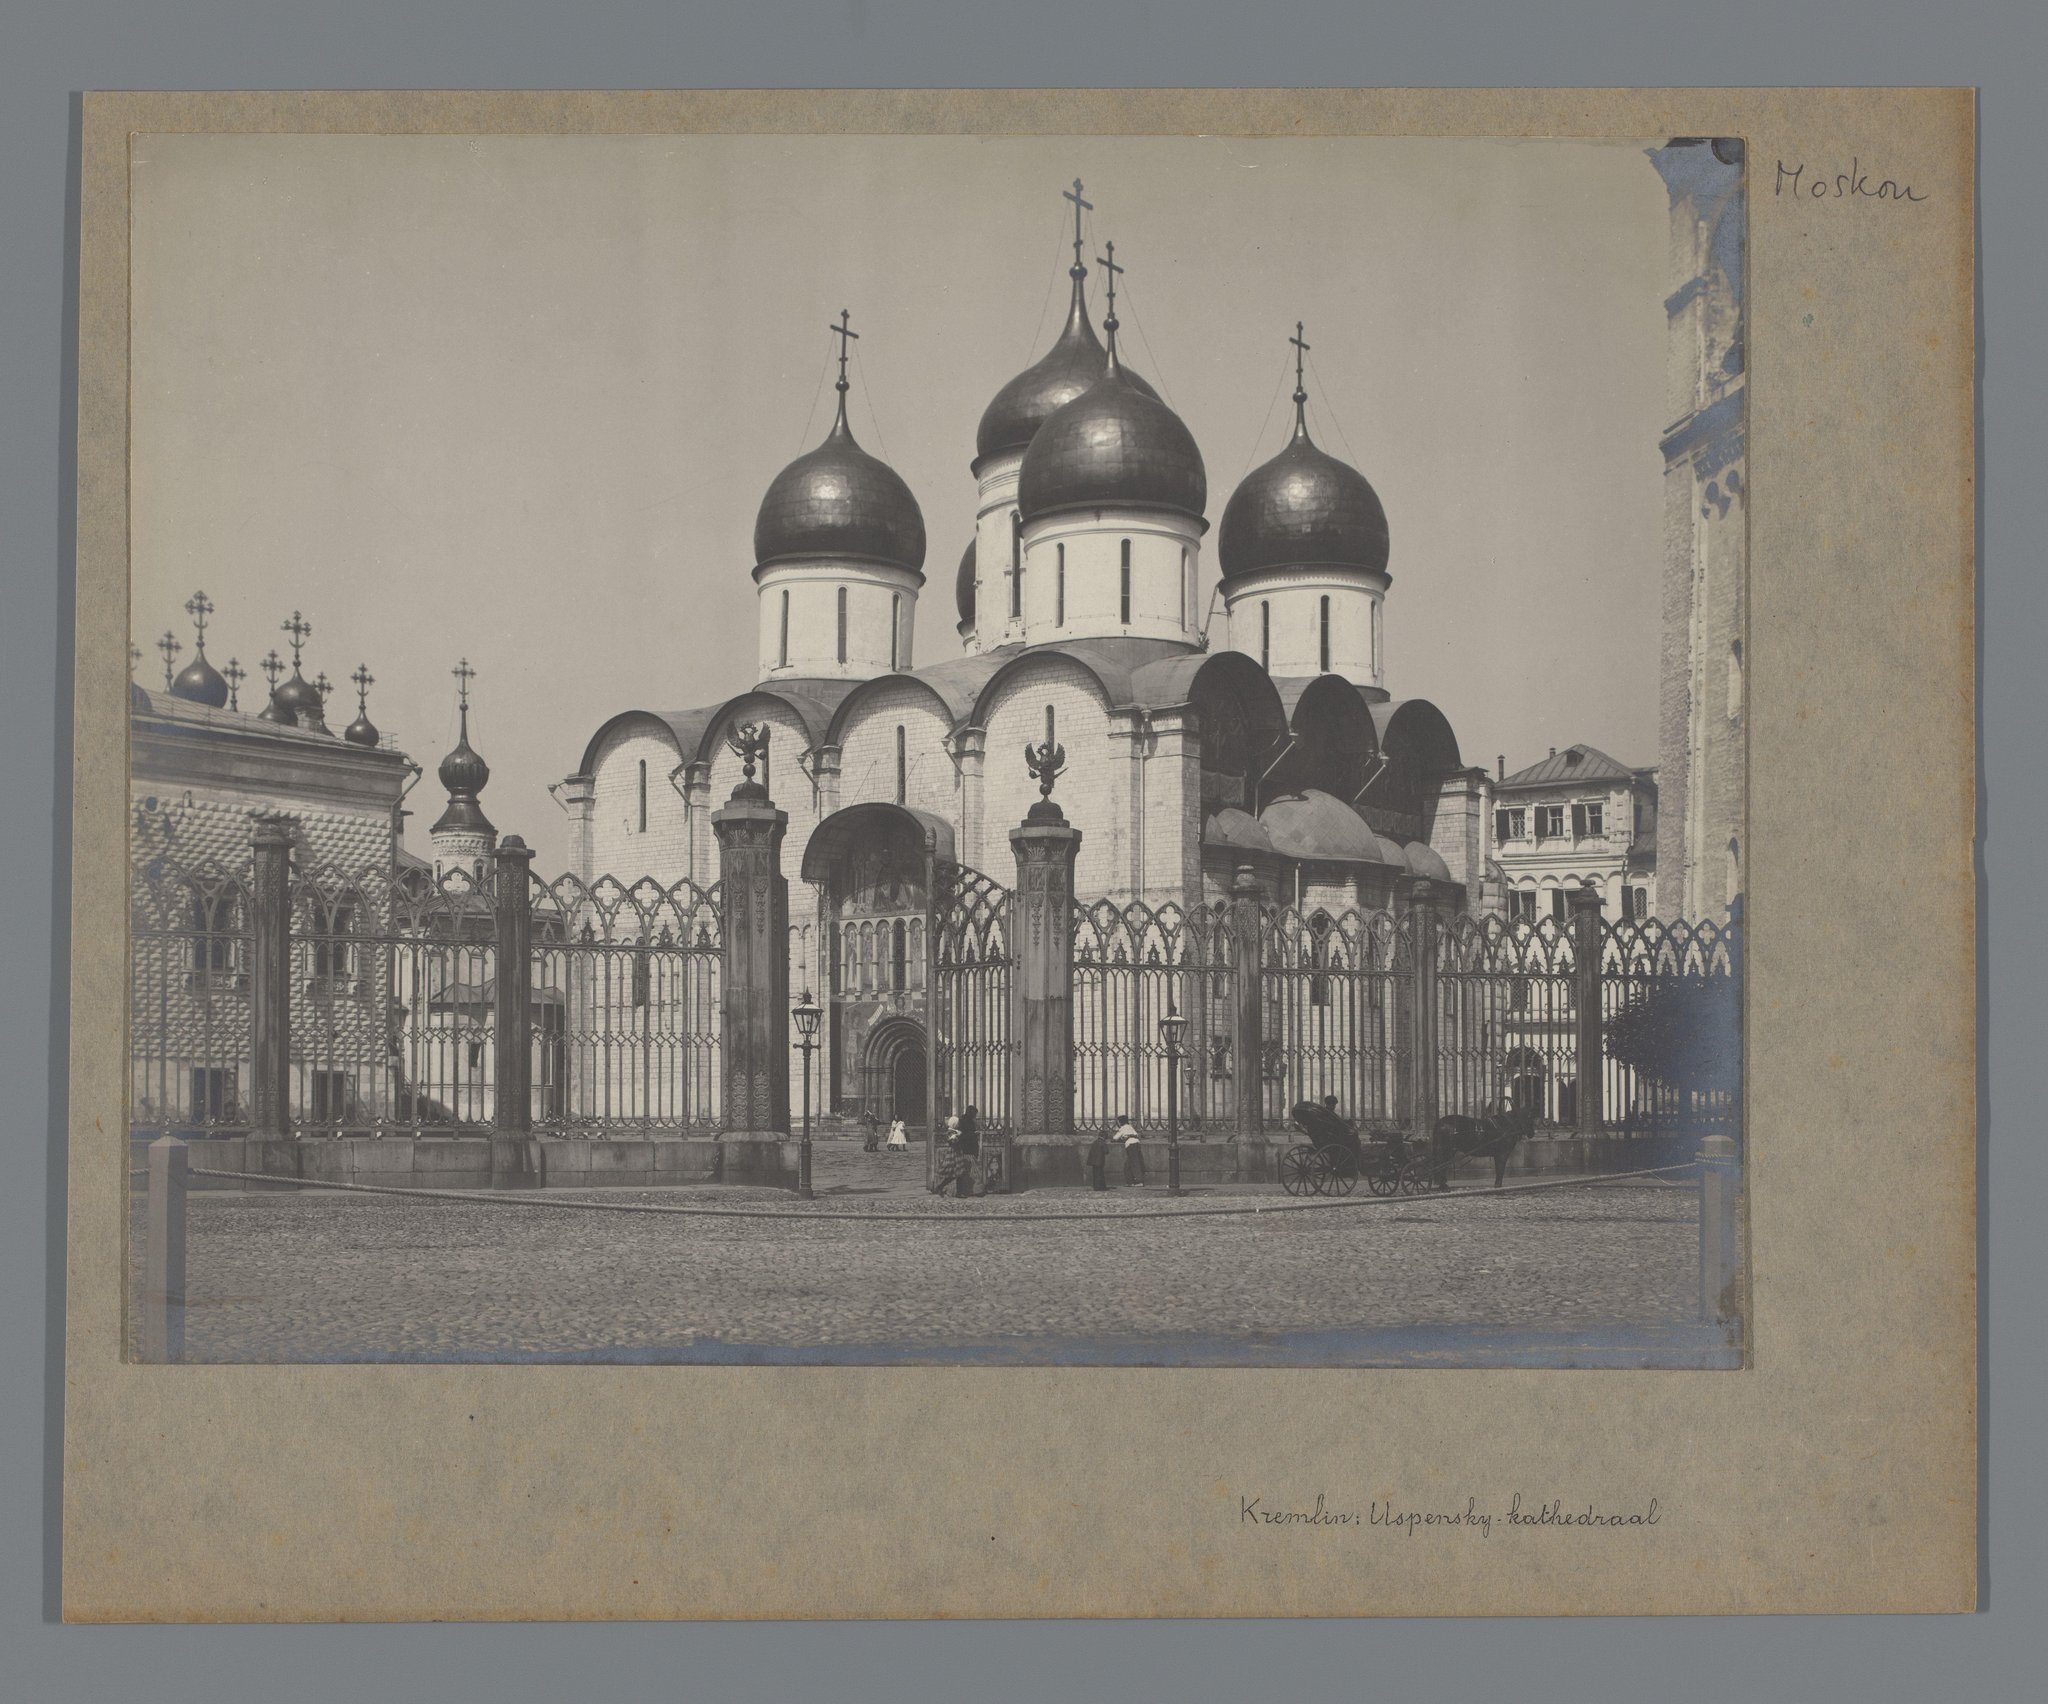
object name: photograph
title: Moskou. Kremlin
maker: Anonymous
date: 1880-1930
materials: photographic support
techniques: gelatin silver print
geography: russia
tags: kremlin